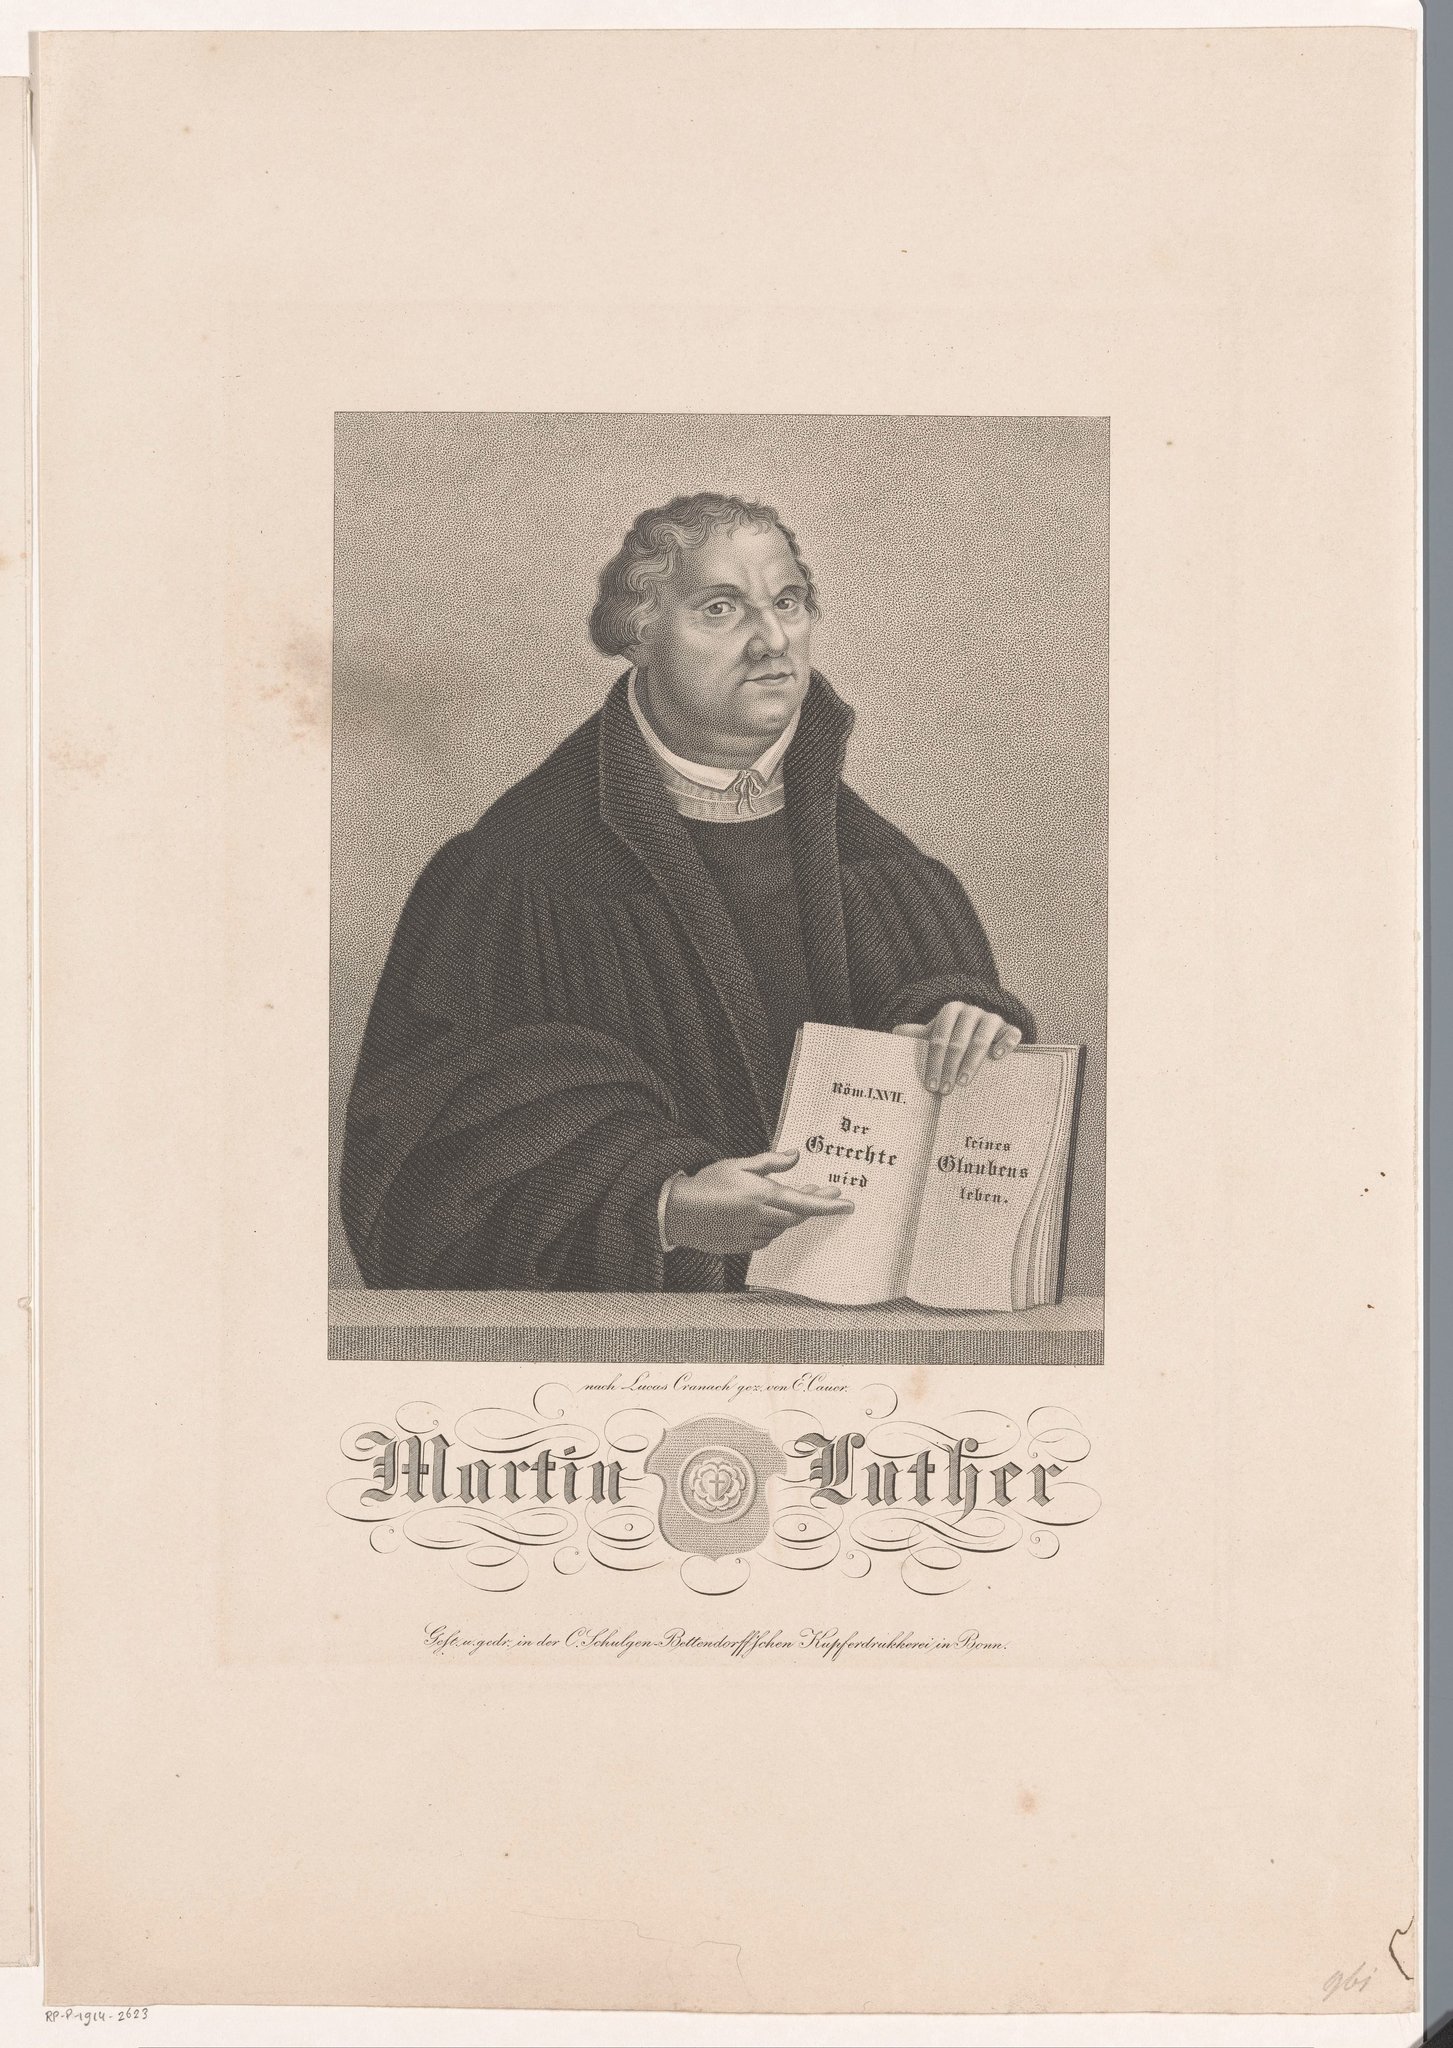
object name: print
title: Portret van Martin Luther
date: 1822-1867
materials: paper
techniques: stippling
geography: bonn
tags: priest, martin luther, historical persons, book - mm - book open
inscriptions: collector's mark: Lugt 2228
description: Prent afkomstig uit een serie met kerkhervormers. Mogelijk maakte Emil Cauer de tekeningen waarop deze prent gebaseerd is in de periode dat hij tekenleraar was in Bonn, van 1826 tot 1829.